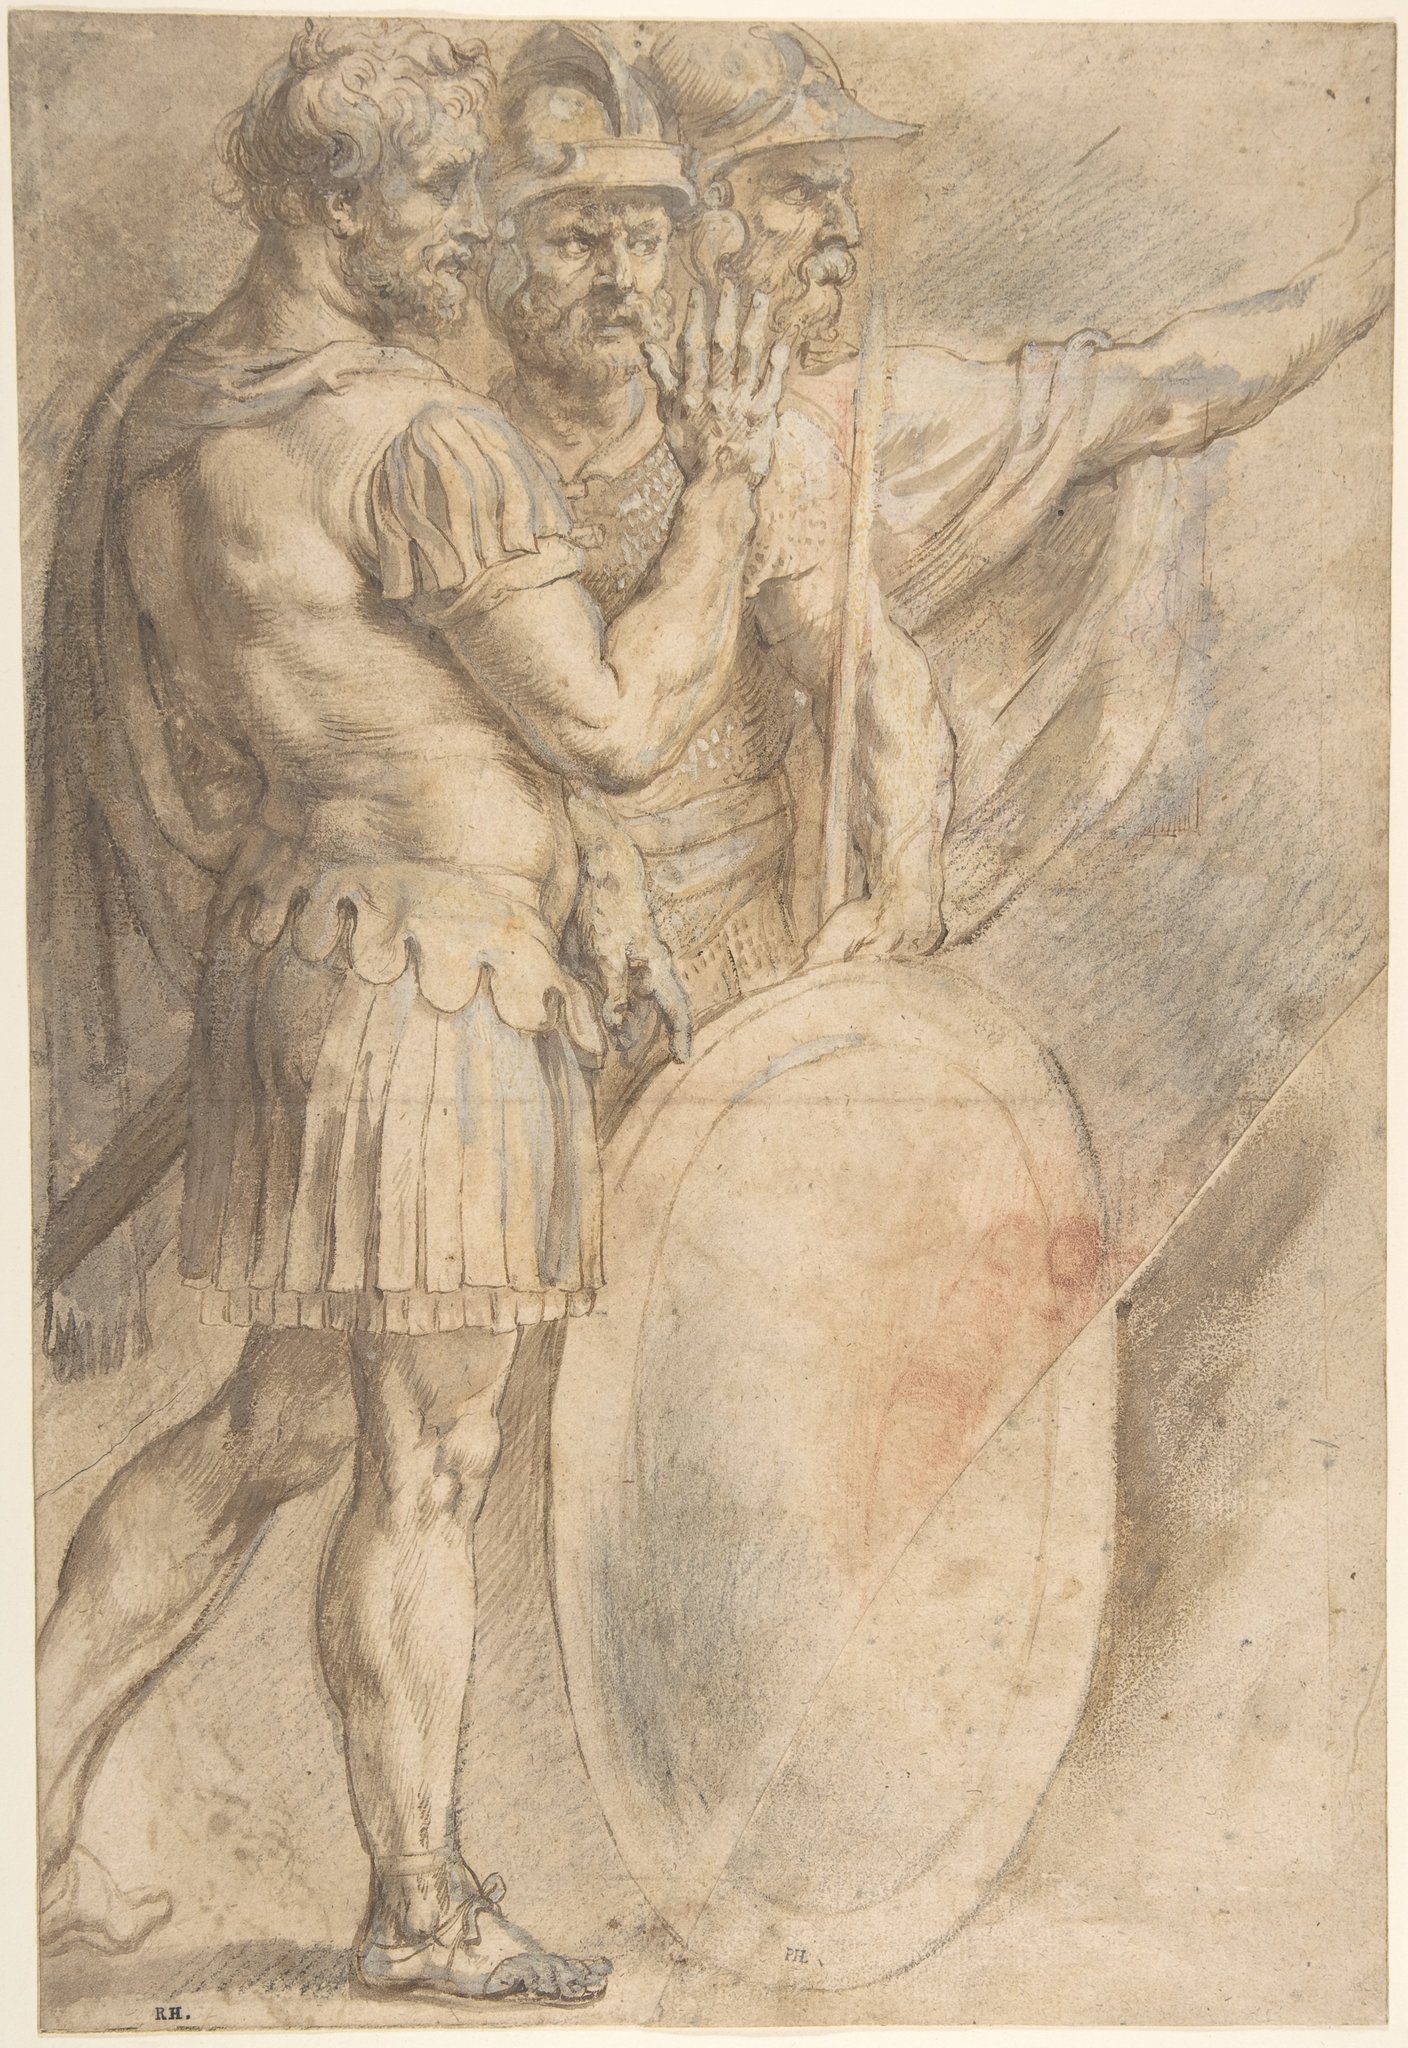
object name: drawing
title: Three Warriors after Raphael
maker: anonymous, italian, 16th century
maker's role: artist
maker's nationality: italian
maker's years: 1500-1600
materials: chalk, ink, oil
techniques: brush, pen, wash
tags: soldiers,shields